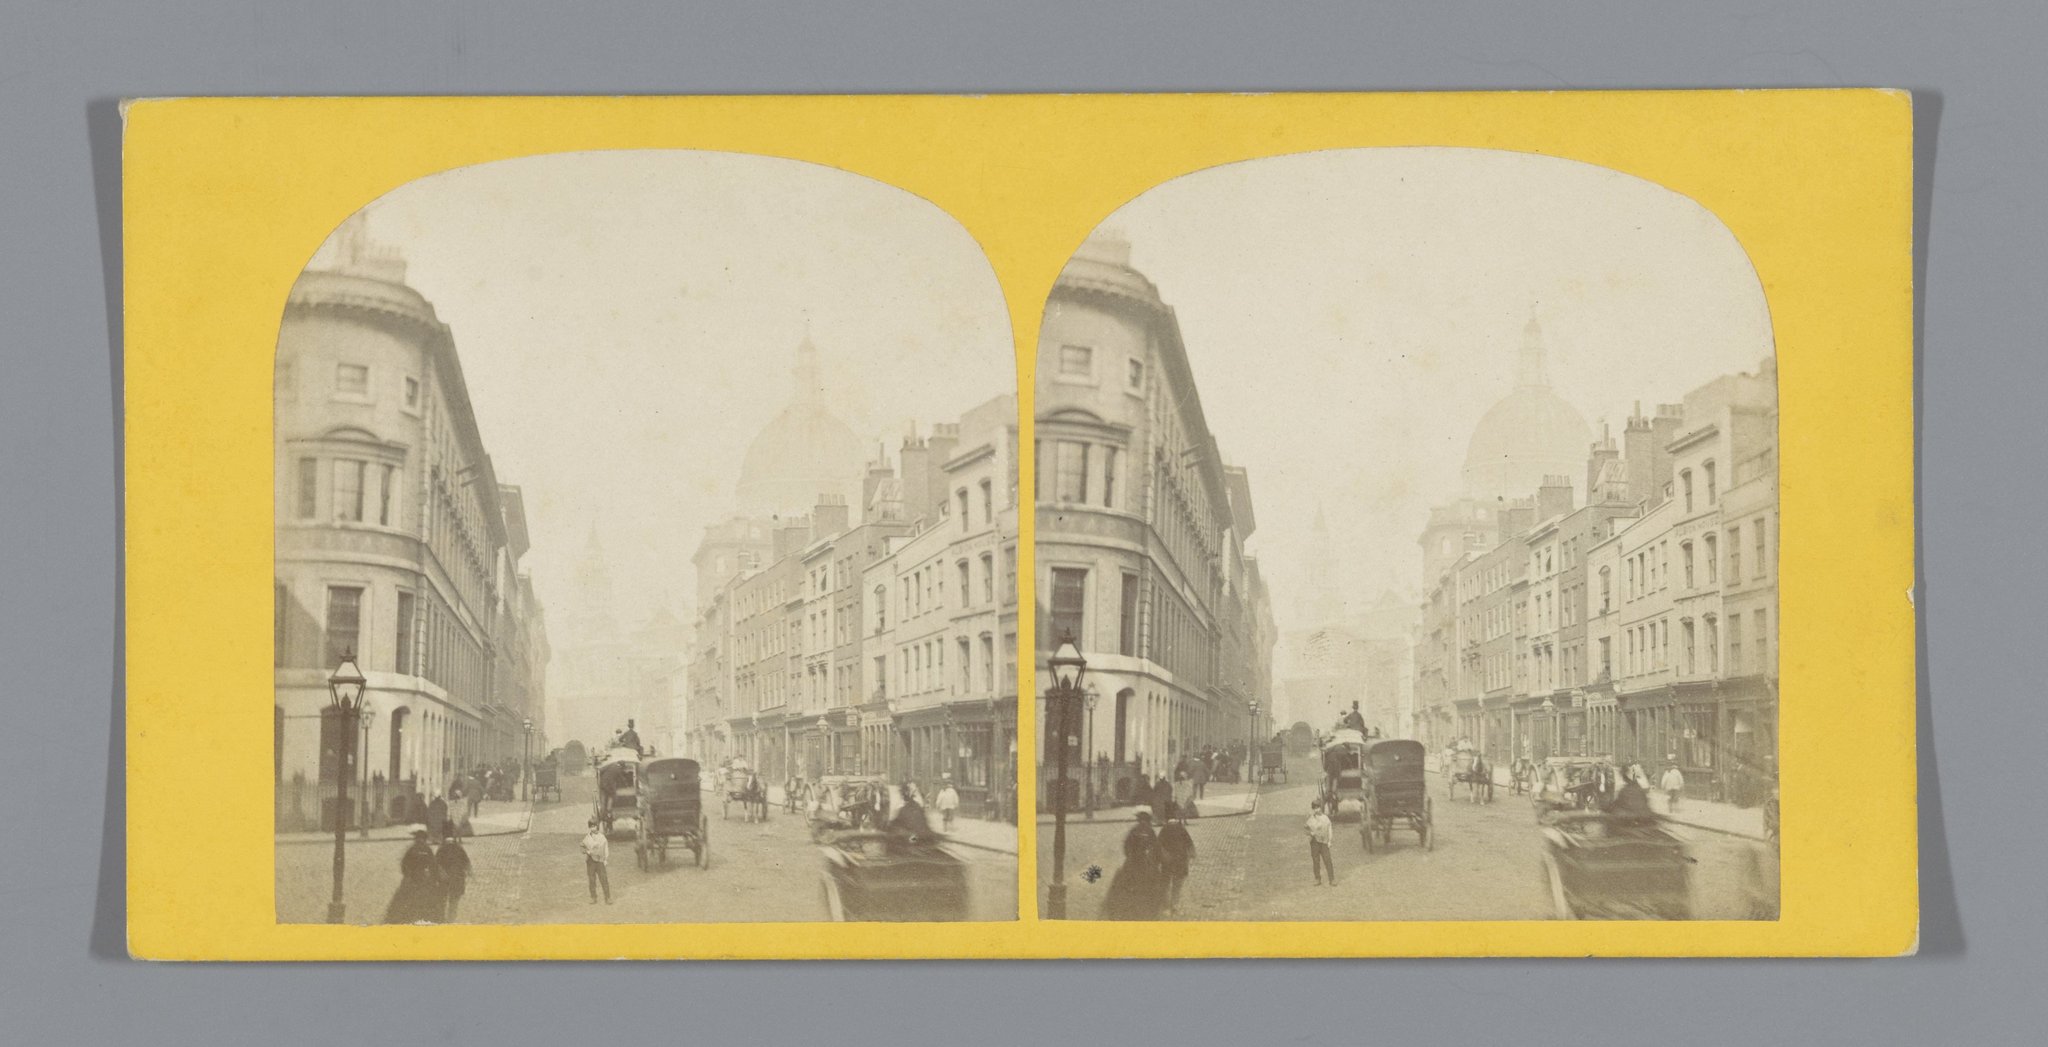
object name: stereograph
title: St. Paul's from Cannon Street West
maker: Anonymous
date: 1850-1880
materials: cardboard, photographic support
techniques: albumen print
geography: london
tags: parts of church exterior and annexes: dome, four-wheeled, animal-drawn vehicle, e.g.: cab, carriage, coach, street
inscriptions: inscription, number: ‘No. 256.’